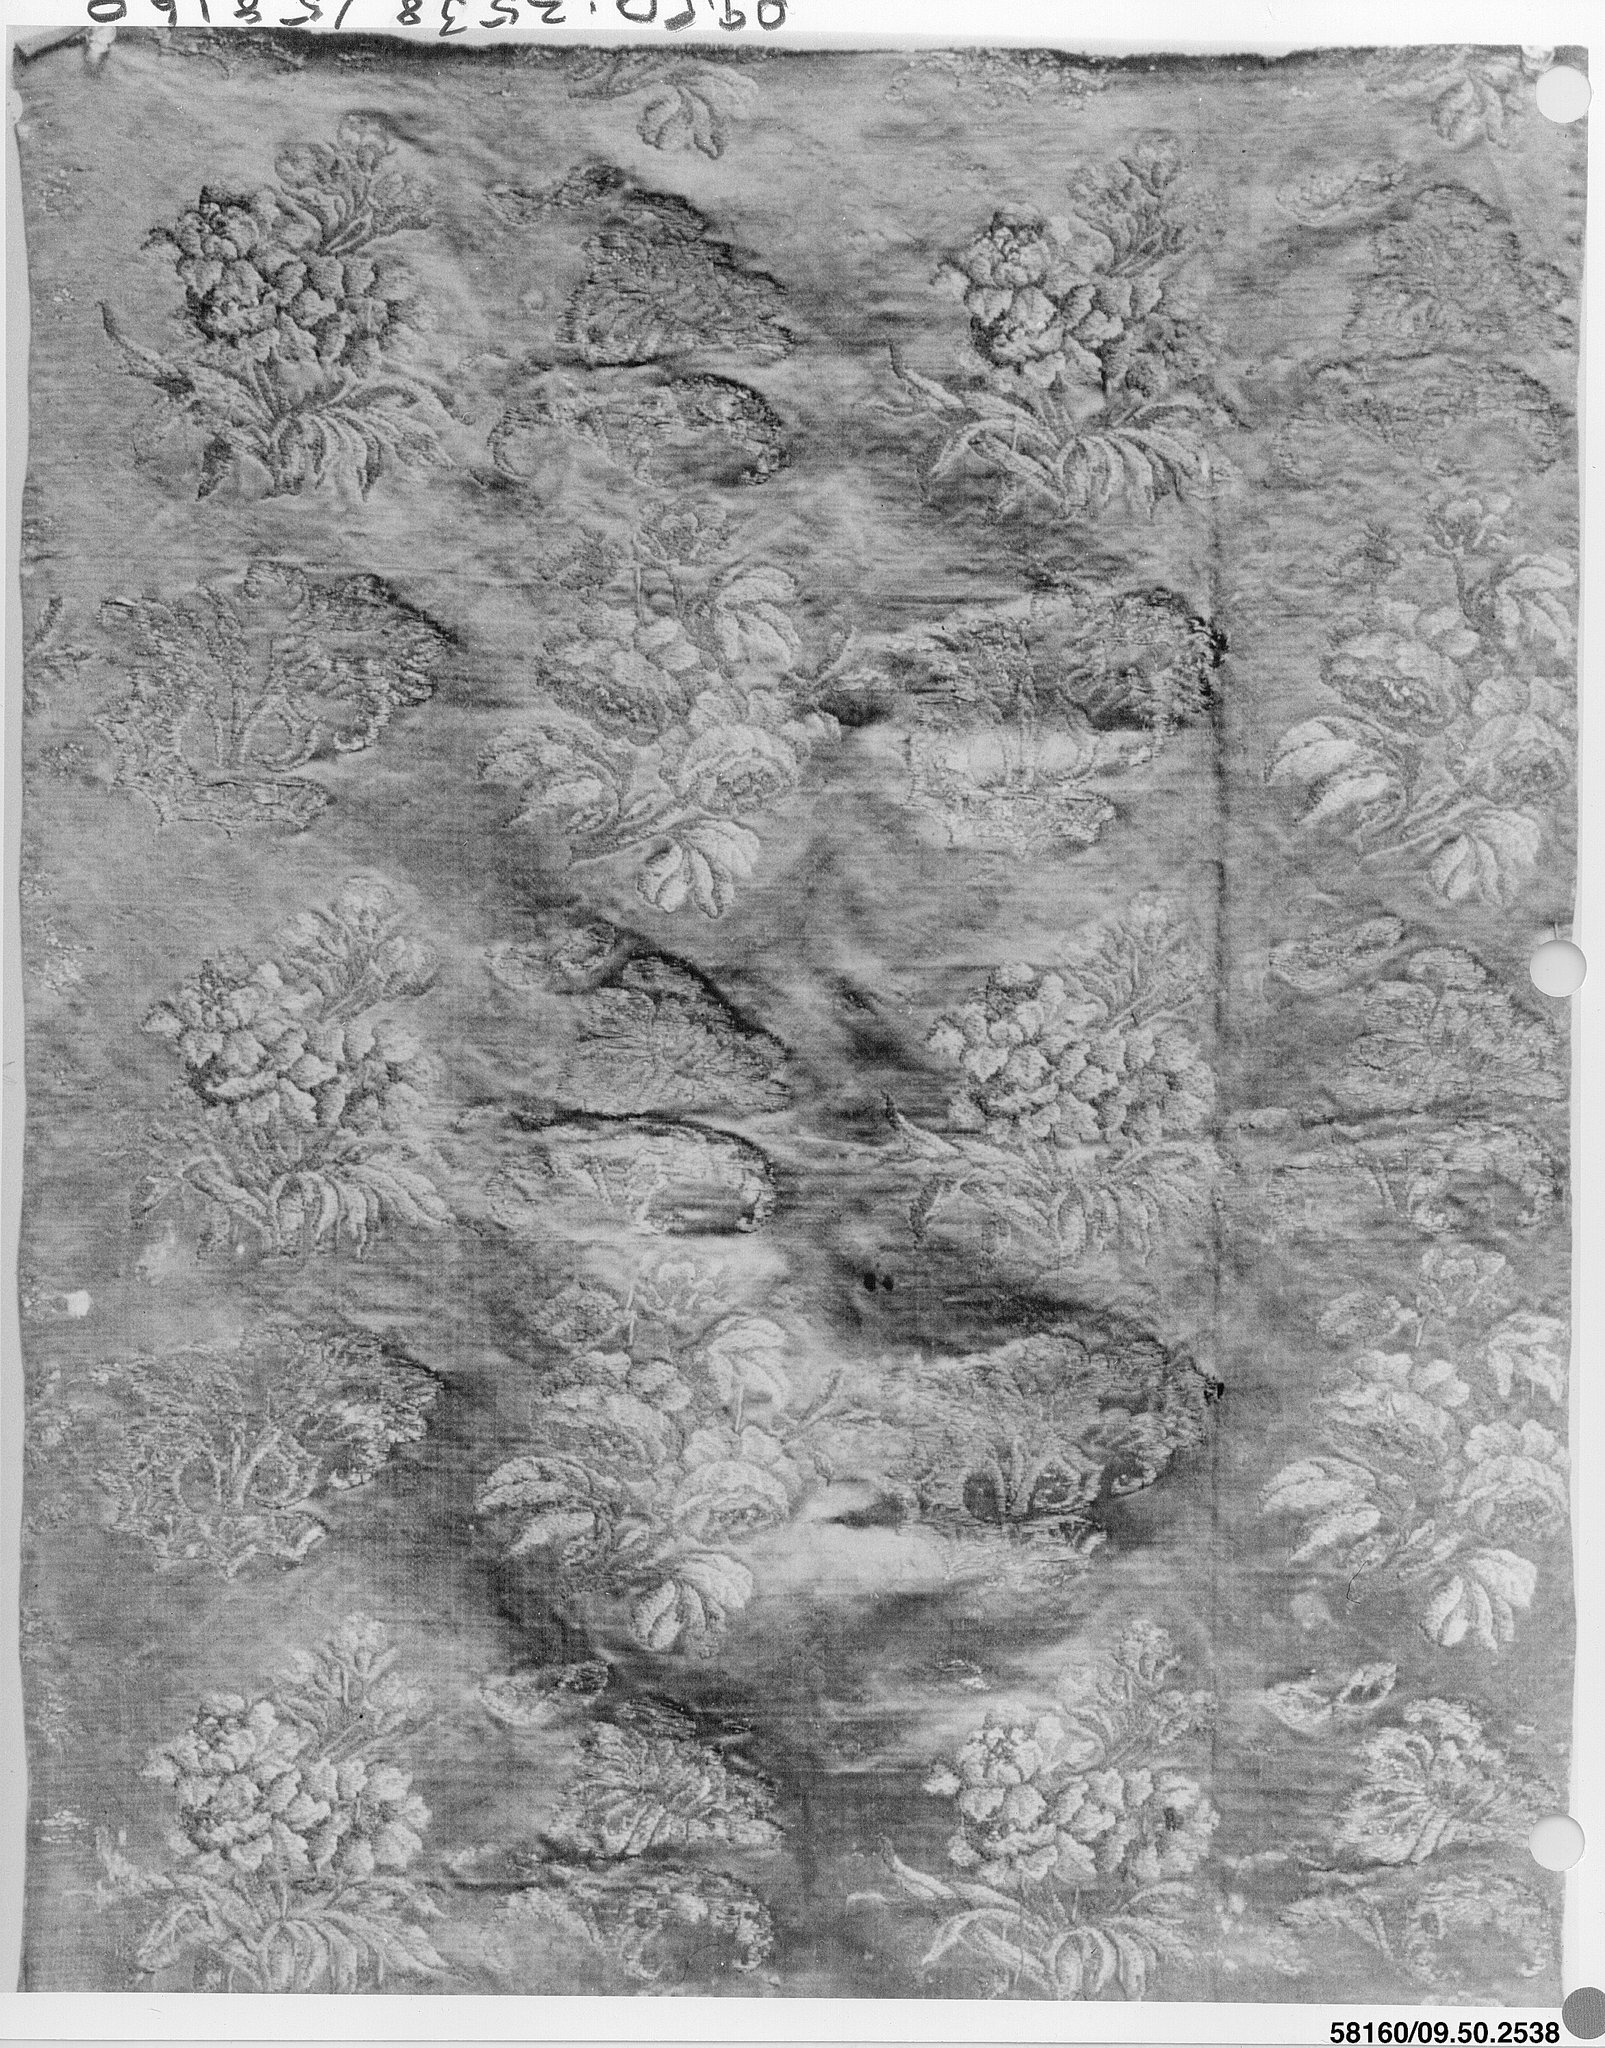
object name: piece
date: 1701-1800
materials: linen, metal thread, silk, wool